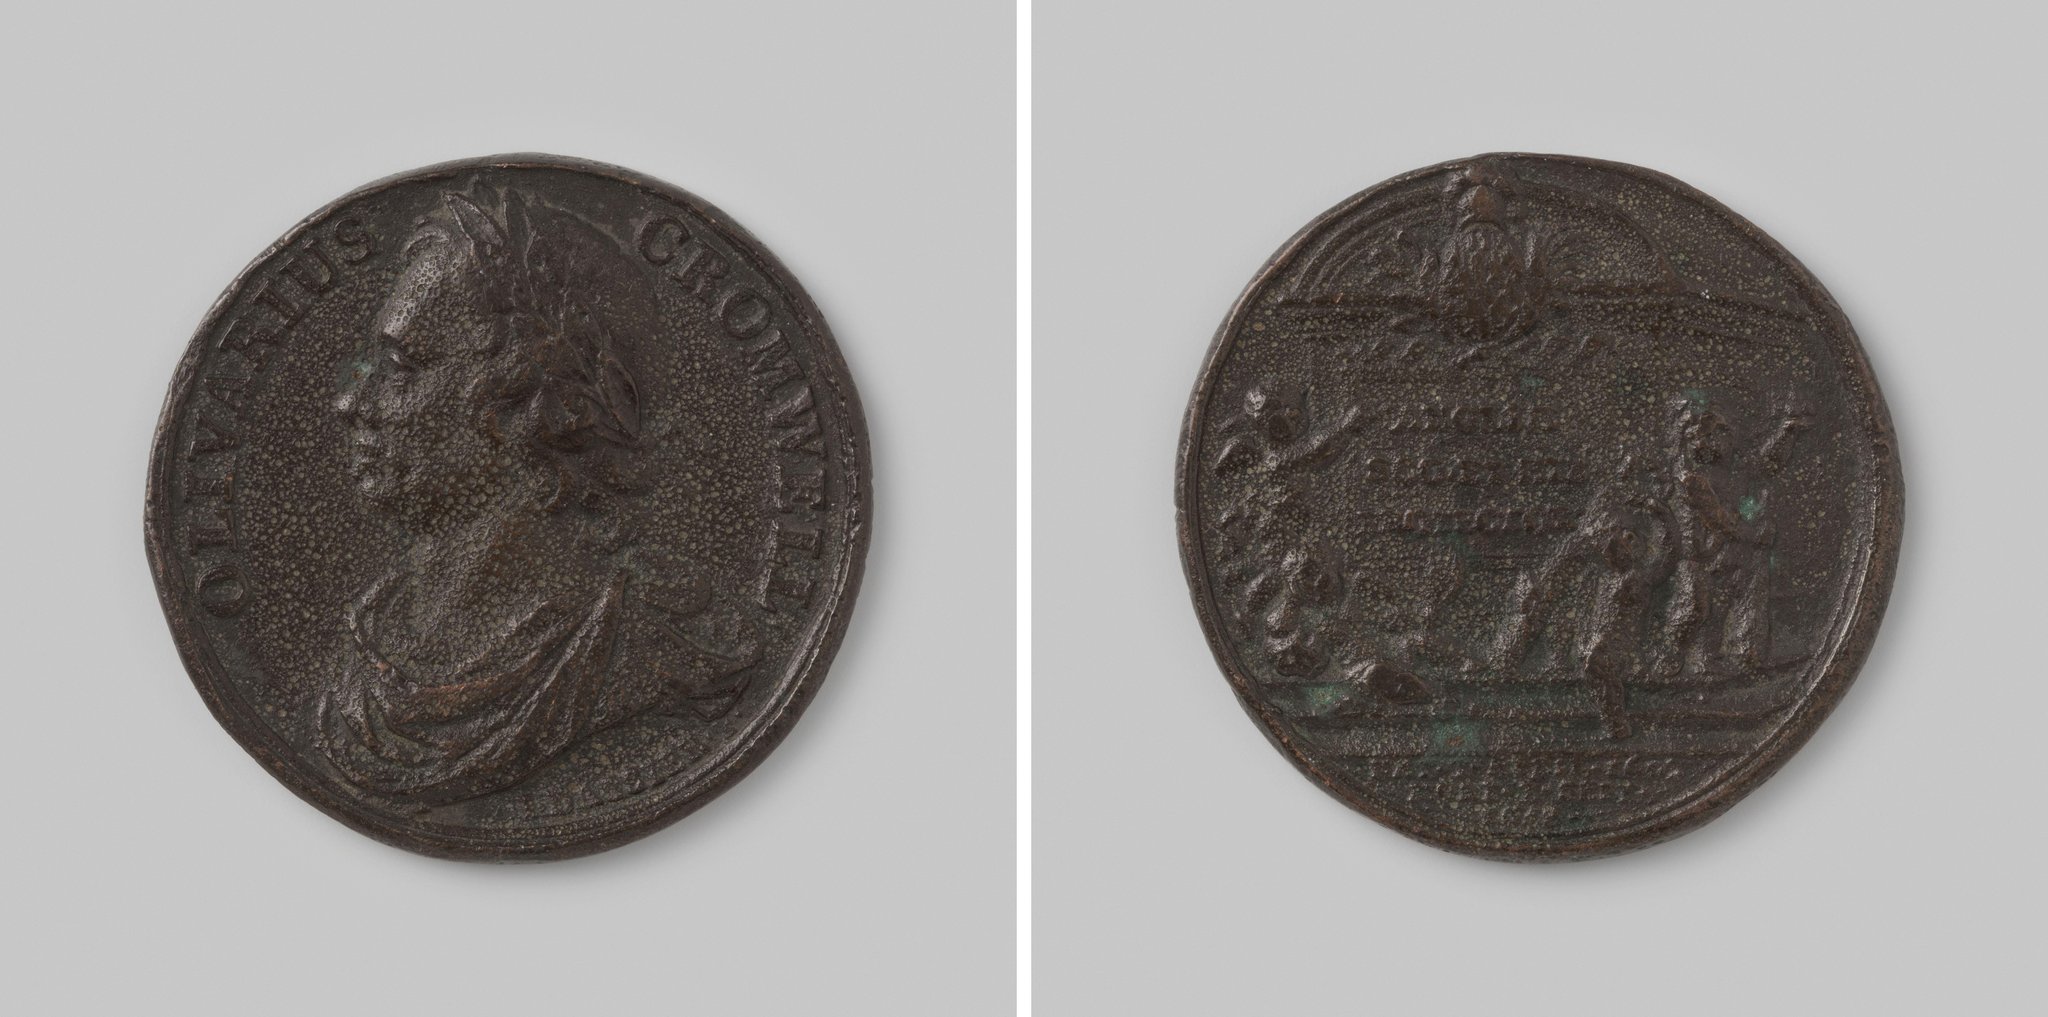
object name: history medal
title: Koningen en koninginnen - Oliver Cromwell 1599-1658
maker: jean dassier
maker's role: medailleur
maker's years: 1676-1763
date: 1658-1731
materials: copper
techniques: casting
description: Donker gekleurde penning, op de voorzijde het borstbeeld van Cromwell naar links met omschrift, op de keerzijde vier putti bij een grafmonumet, met afsnedetekst